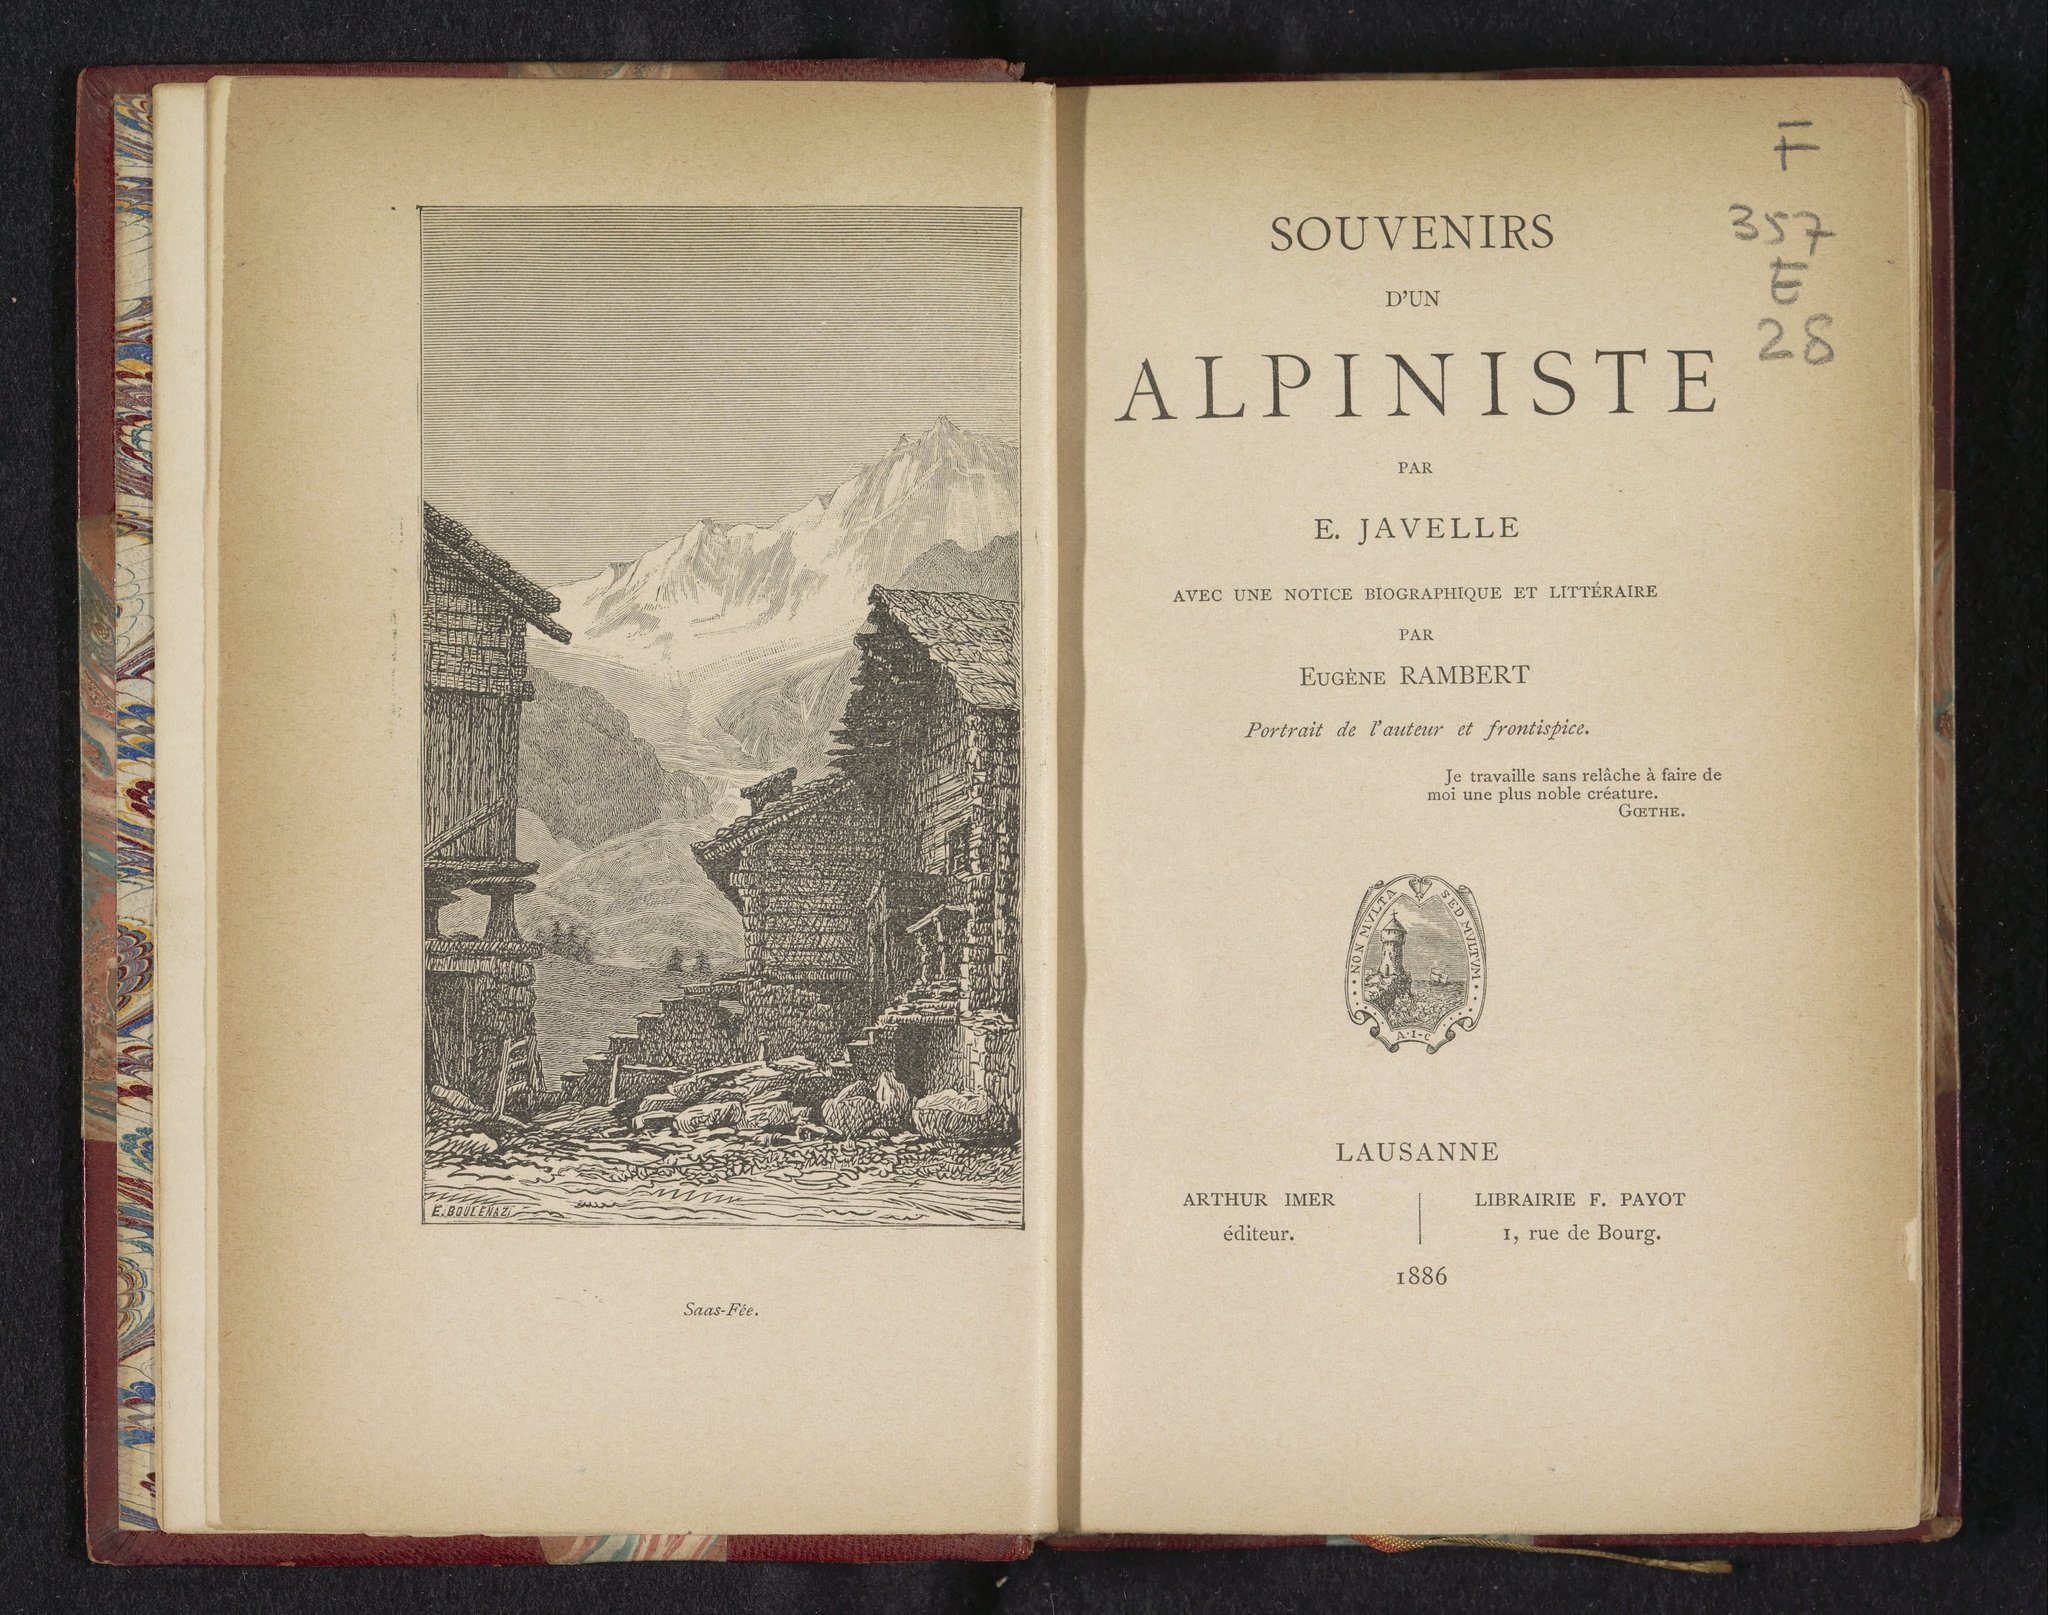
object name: book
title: Souvenirs d'un alpiniste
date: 1886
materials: cardboard, leather, paper, photographic support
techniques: albumen print, combed marbled paper, marbled paper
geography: lausanne